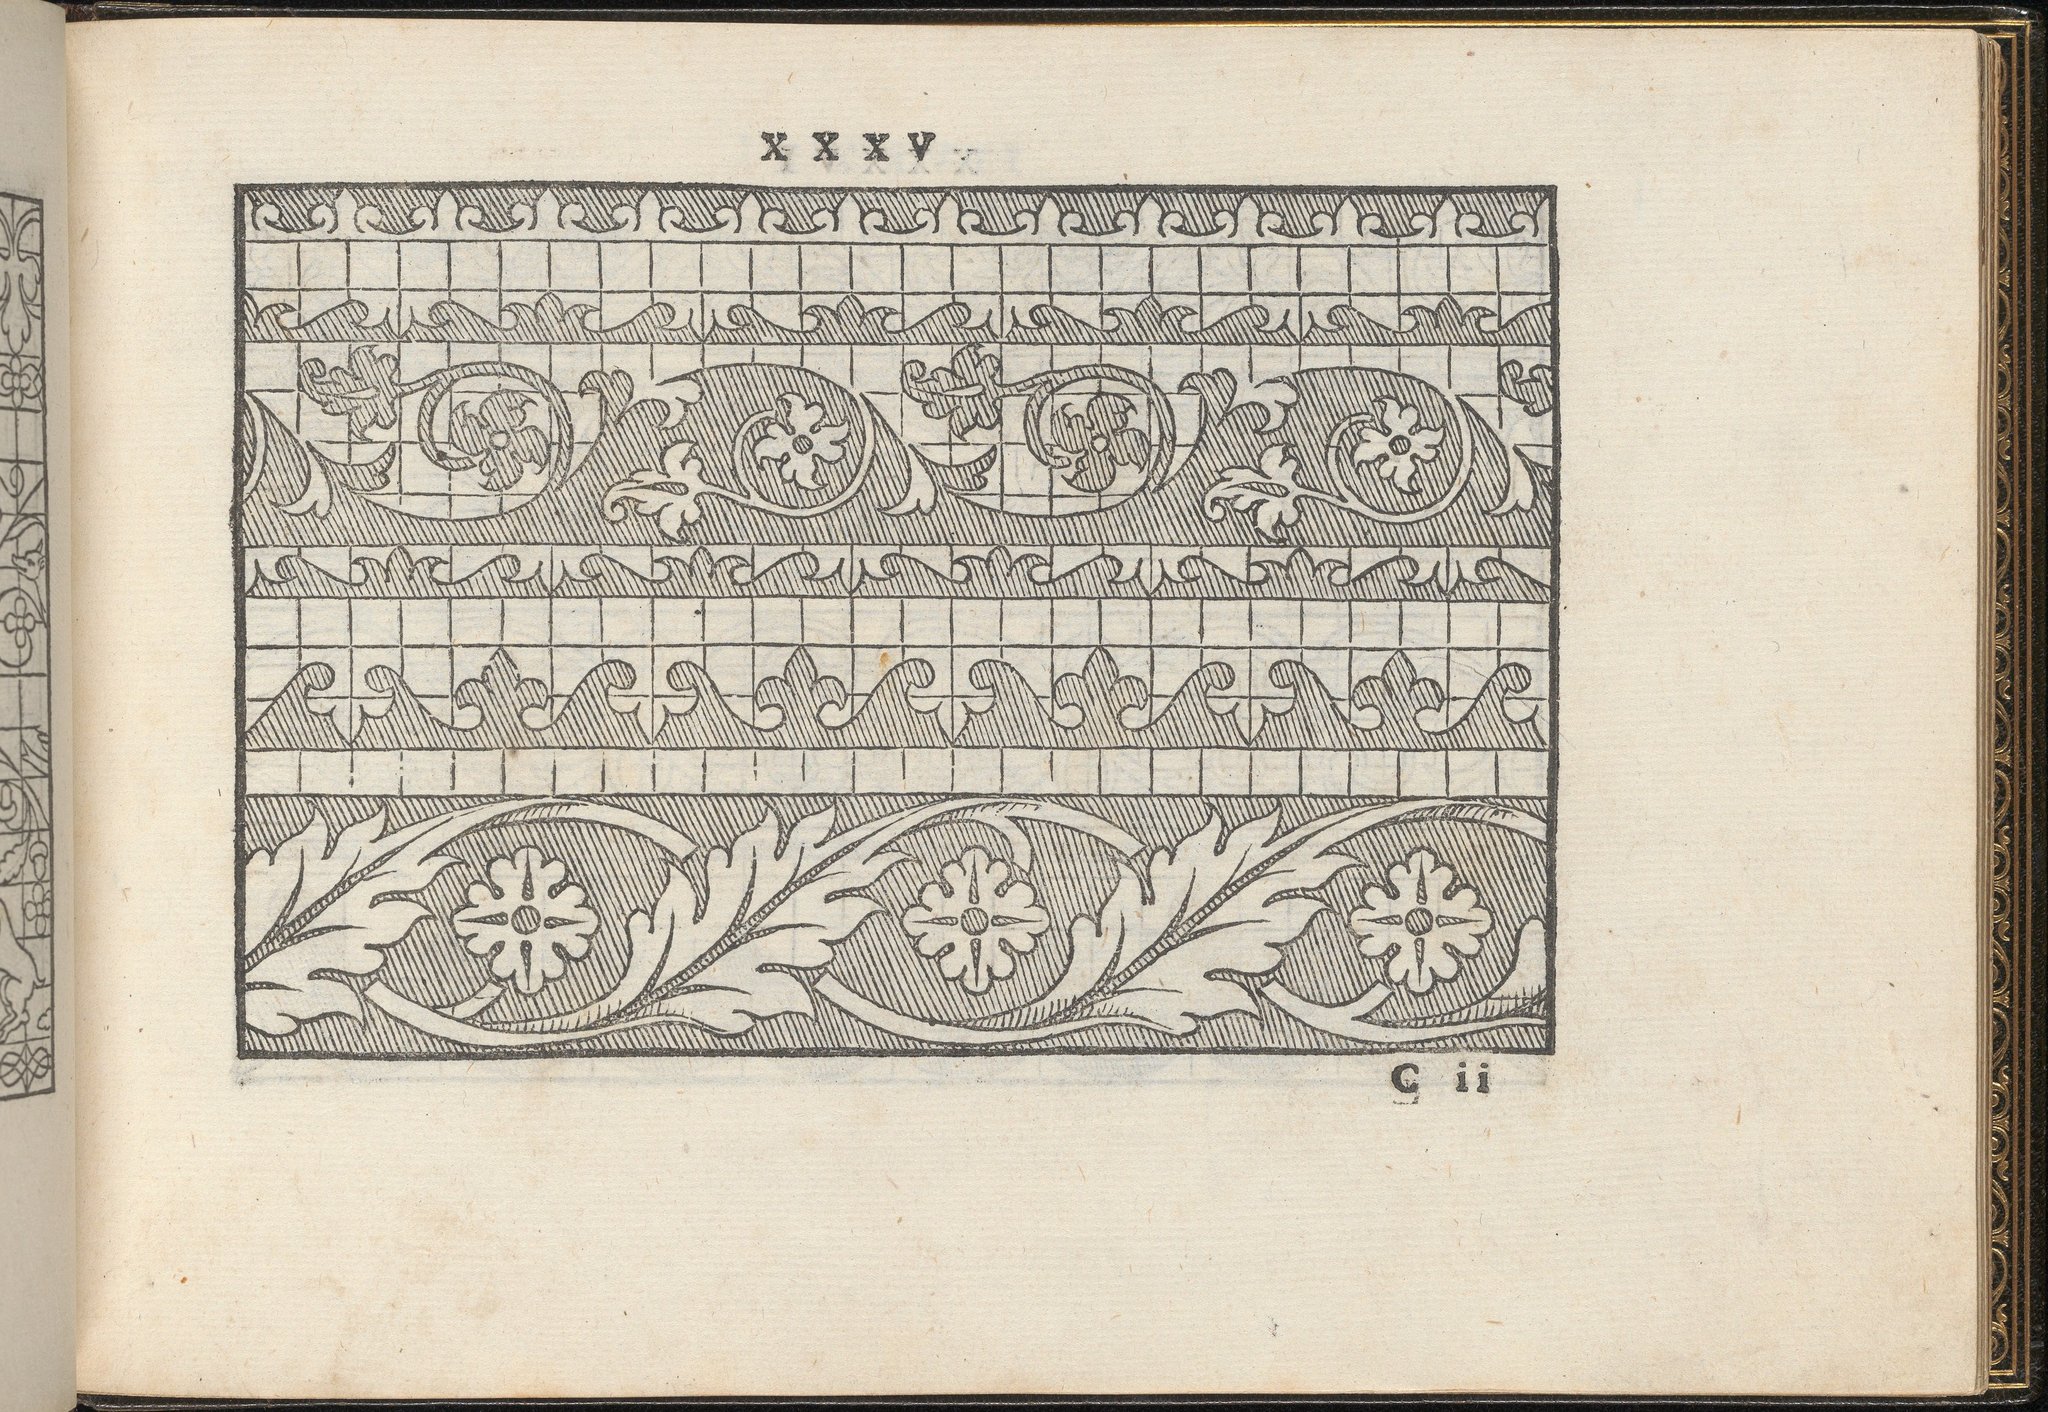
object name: book print ornament architecture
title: La Vera Perfettione del Disegno di varie sorti di recami, page 18 (recto)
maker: giovanni ostaus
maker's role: publisher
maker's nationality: italian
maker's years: 1507-1607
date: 1567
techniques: woodcut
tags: flowers